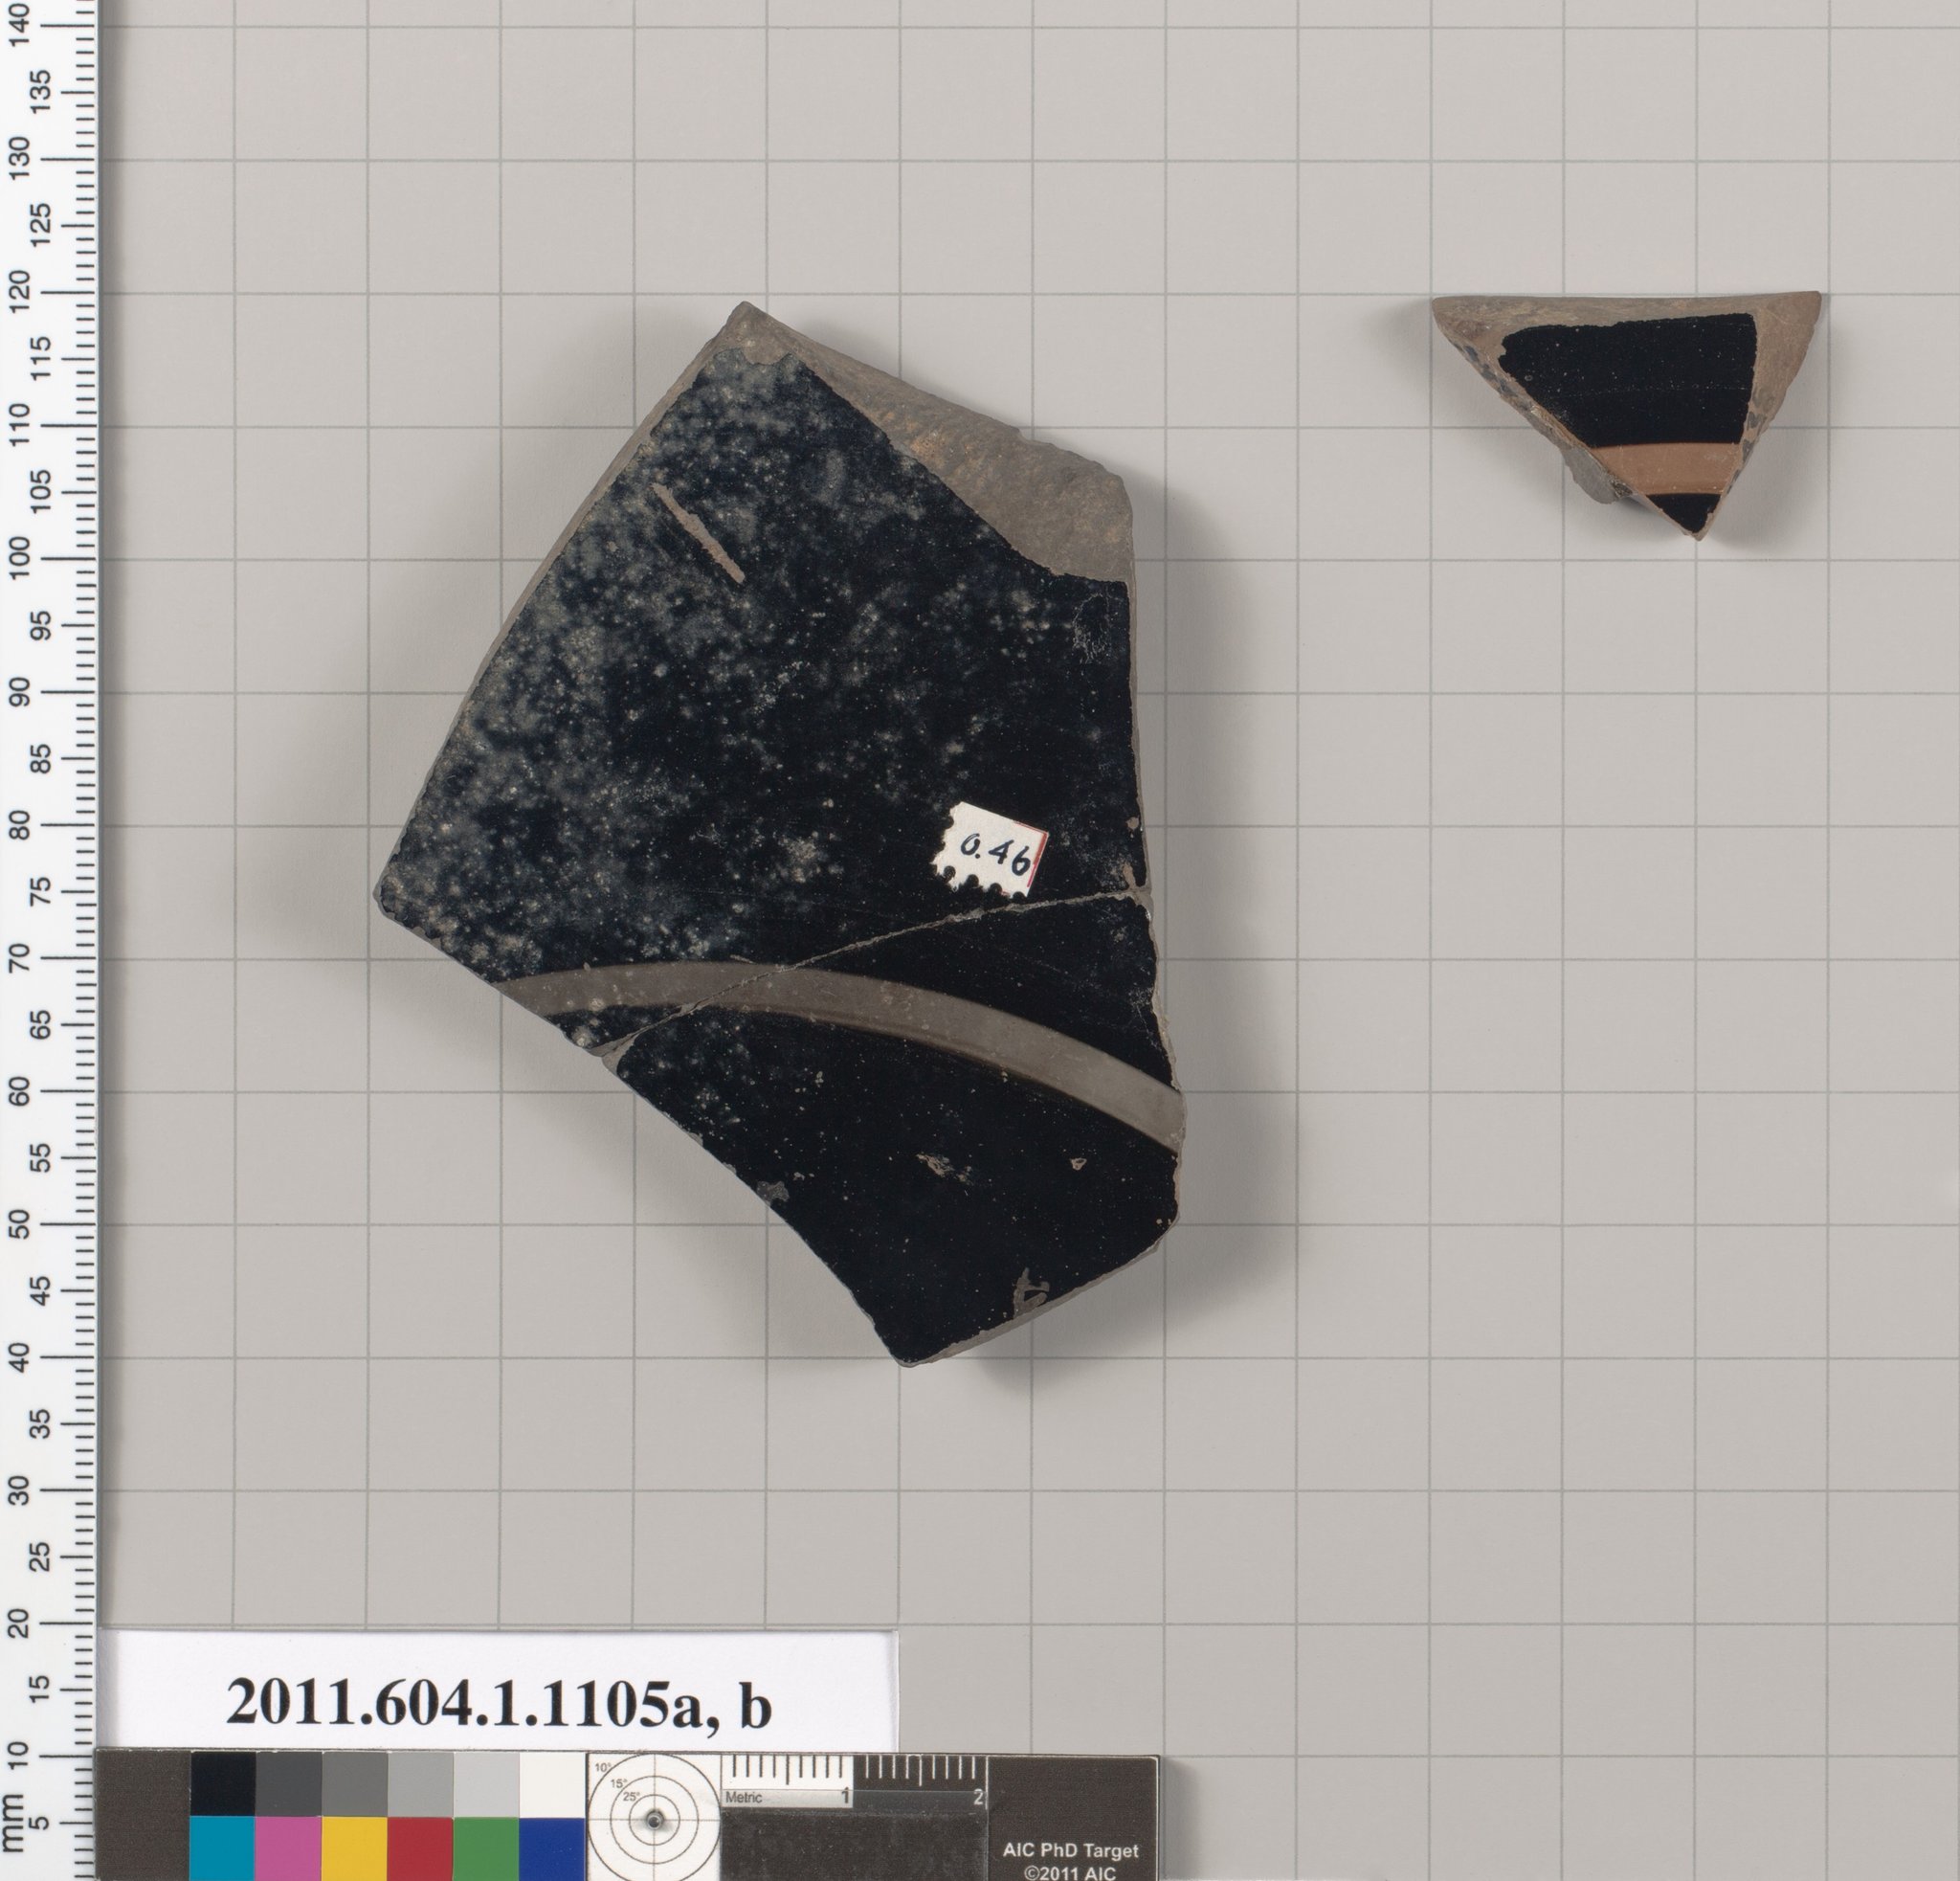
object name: kylix fragment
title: Terracotta fragments of a kylix (drinking cup)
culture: greek, attic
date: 520-500 BCE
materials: terracotta